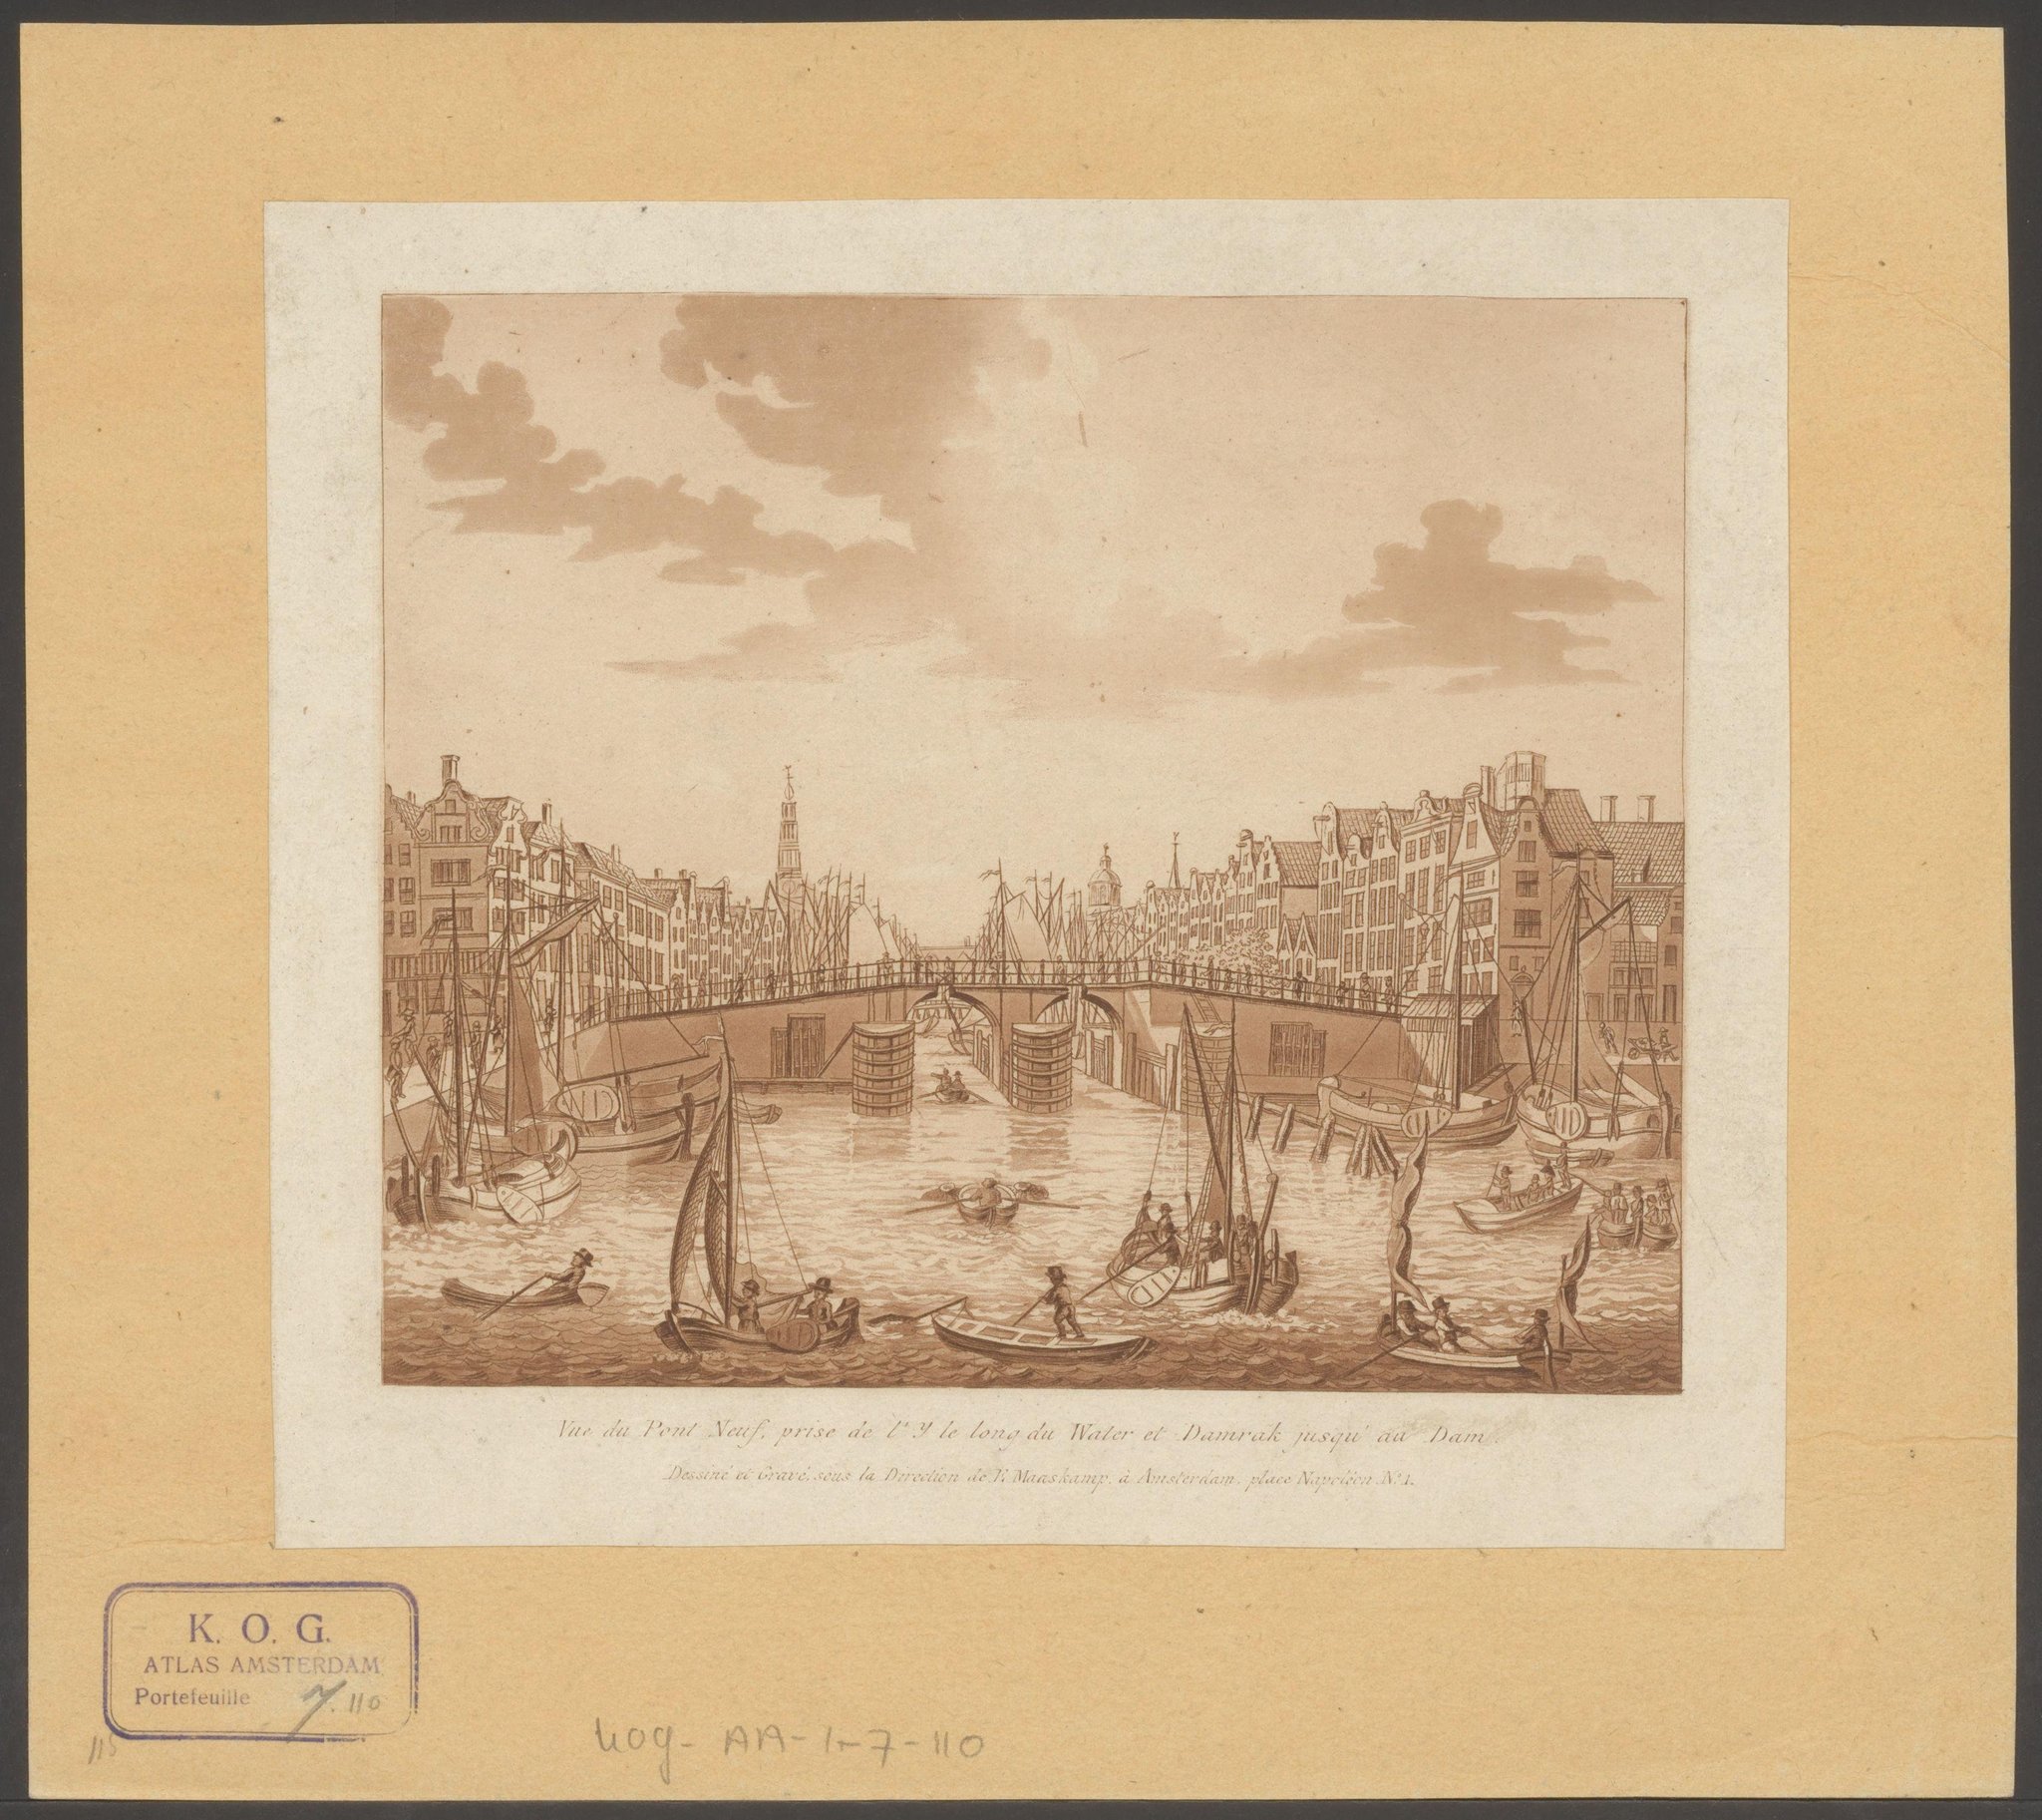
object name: print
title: Gezicht op het Damrak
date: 1787-1834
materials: paper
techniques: aquatint, etching, roulette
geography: amsterdam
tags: sailing-ship, sailing-boat, city-view in general; 'veduta', canal, bridge in city across river, canal, etc.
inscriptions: collector's mark: ‘7’ Lugt 1641b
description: Onderwerpsrubriek binnen de Atlas Amsterdam: Damrak, Damstraat, Doelensluis, Doelenstraat (Nieuwe), Driehoekstraat, Droogbak, Duvelshoek, Dijkstraat en Korte -.